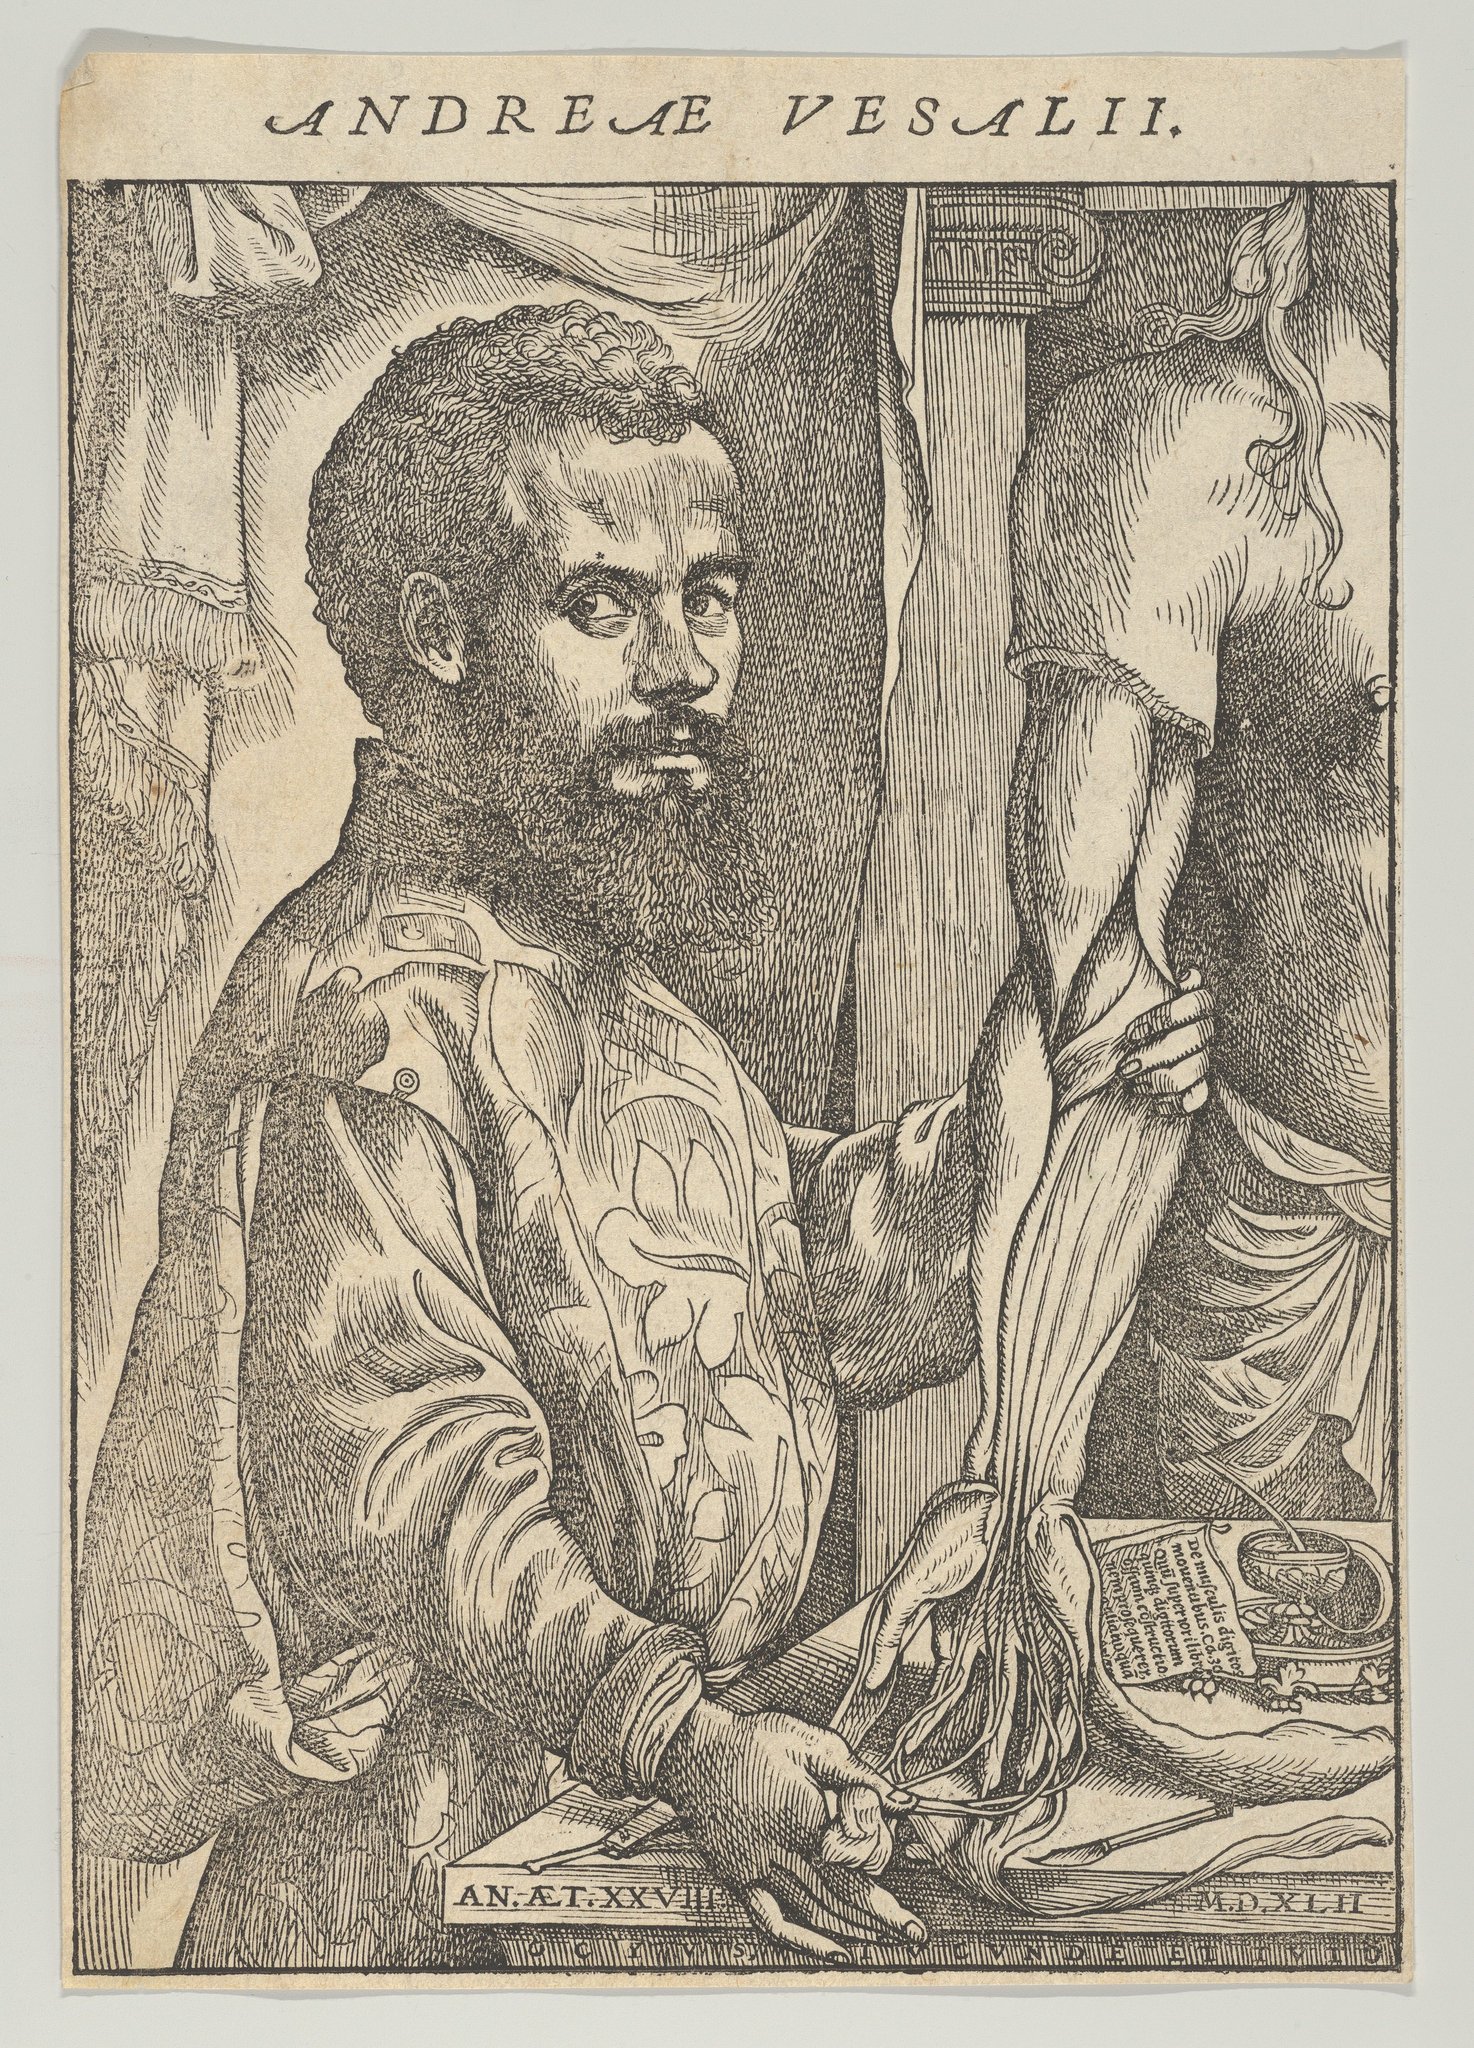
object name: print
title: Portrait of Andreas Vesalius, half-length in profile standing in front of a table dissecting the arm of a body; frontispiece to Andreas Vesalius 'De humani corporis fabrica libri septem'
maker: john of calcar (john stephen calcar)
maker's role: artist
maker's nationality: netherlandish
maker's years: 1499-1550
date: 1542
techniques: woodcut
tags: hands,men,portraits